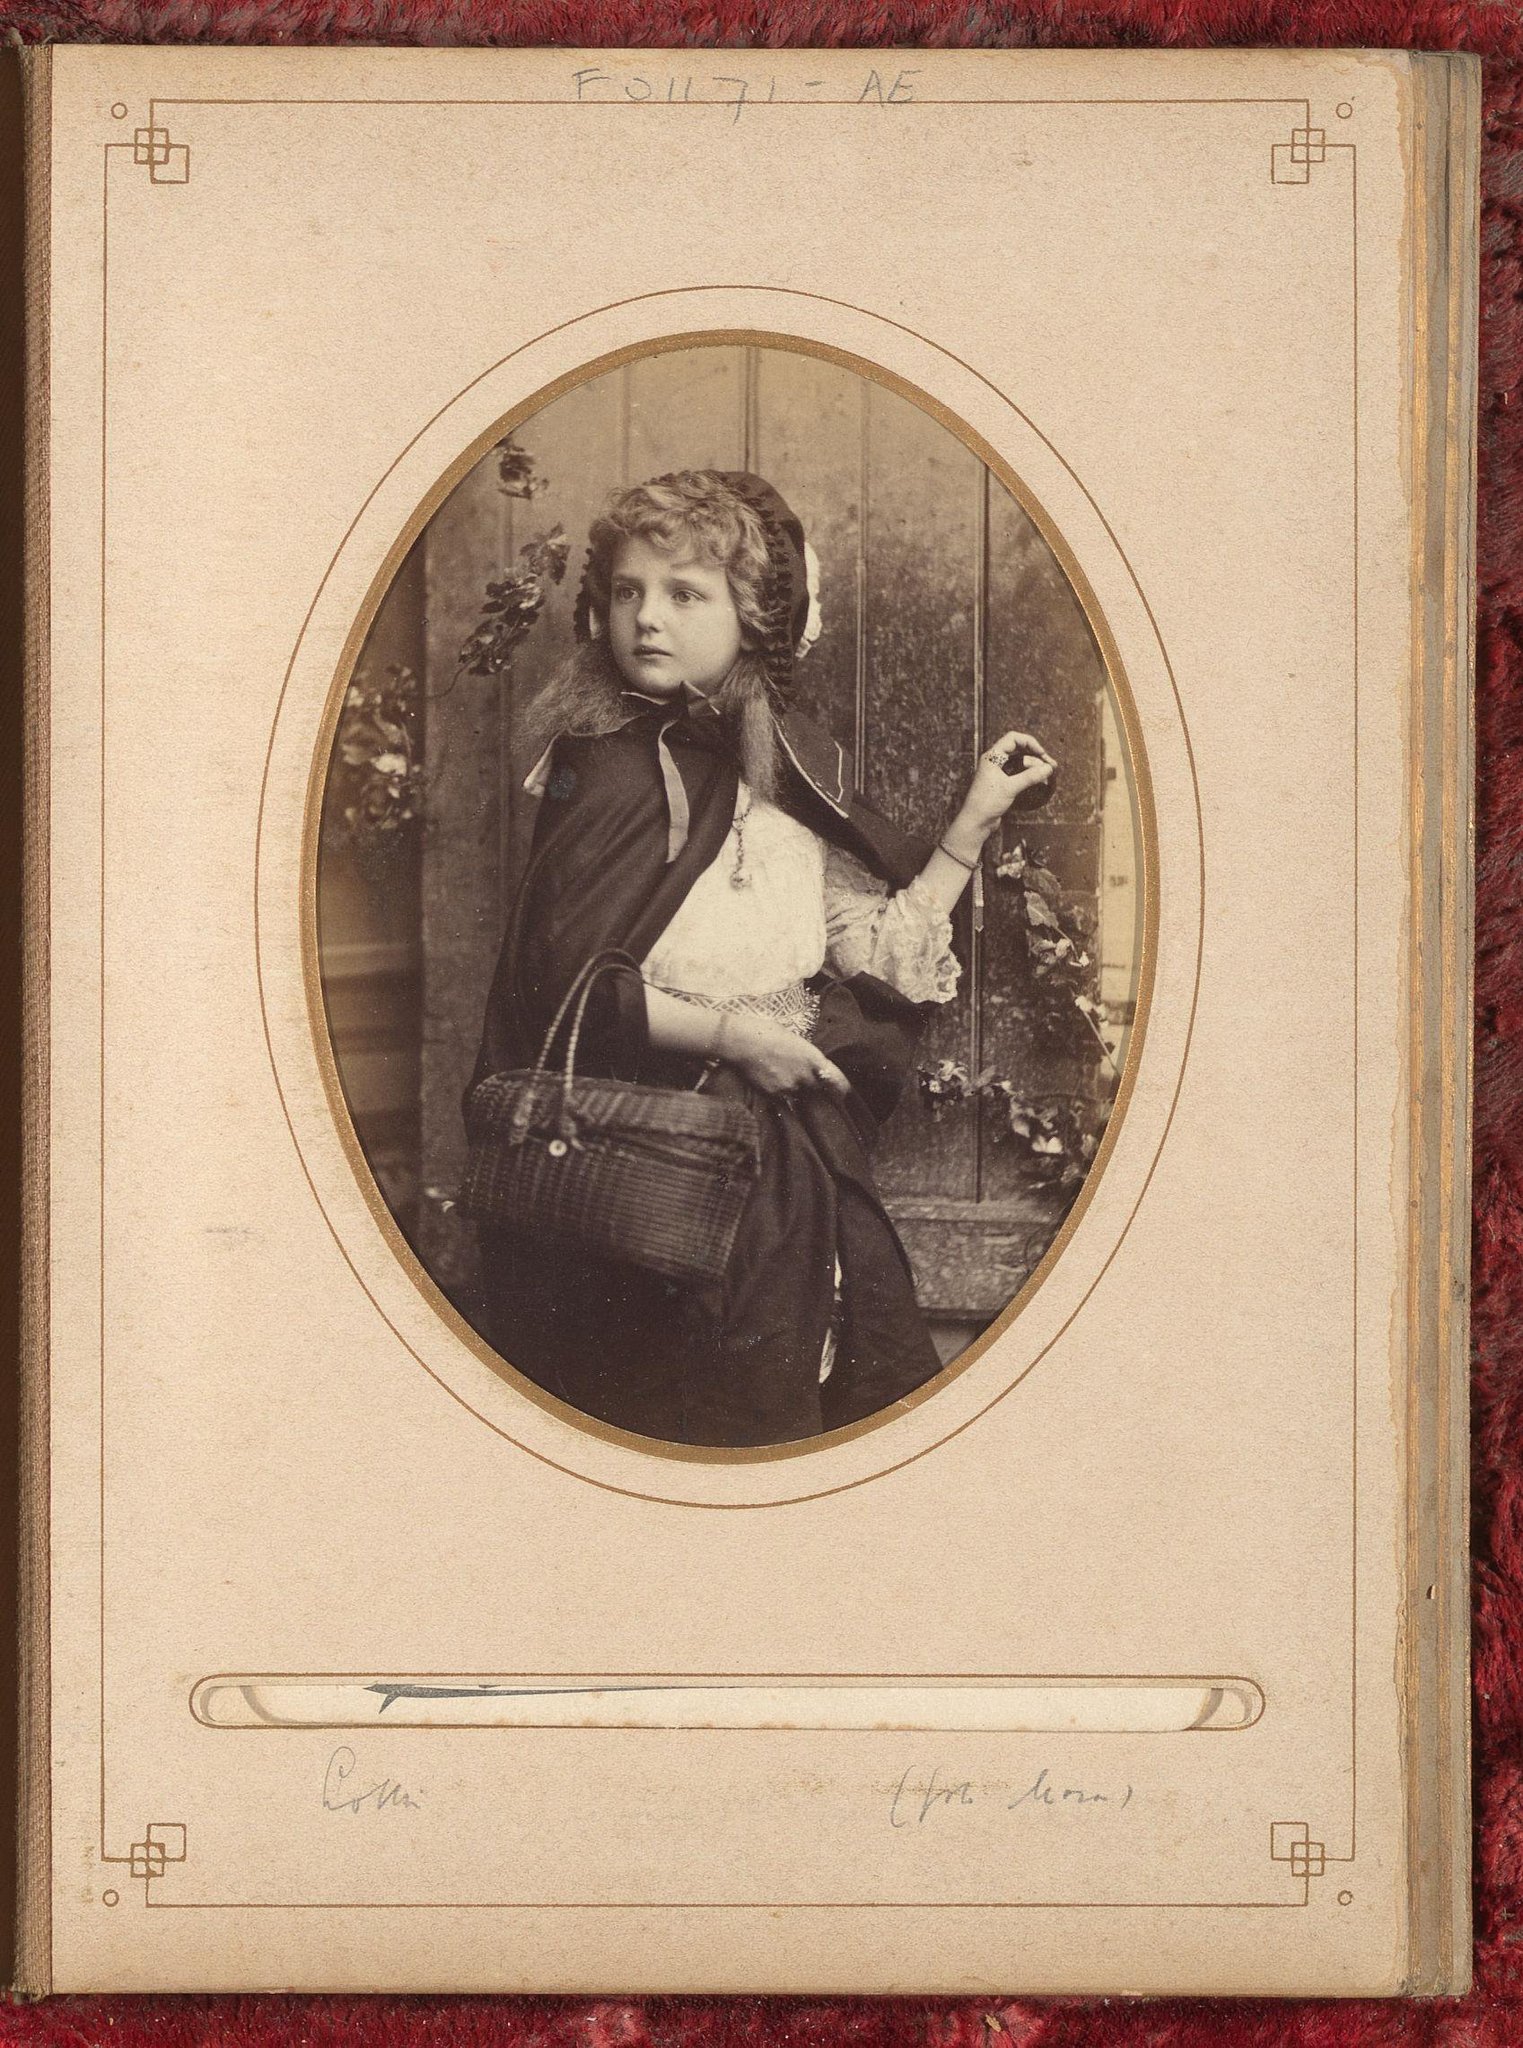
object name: album leaf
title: Lottie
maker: josé maria mora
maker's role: fotograaf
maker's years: 1849-1926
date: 1870-1900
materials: cardboard, photographic support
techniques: albumen print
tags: girl (child between toddler and youth)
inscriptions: number: ‘62’, name: ‘Mora, 707 Broadway, N.Y.’